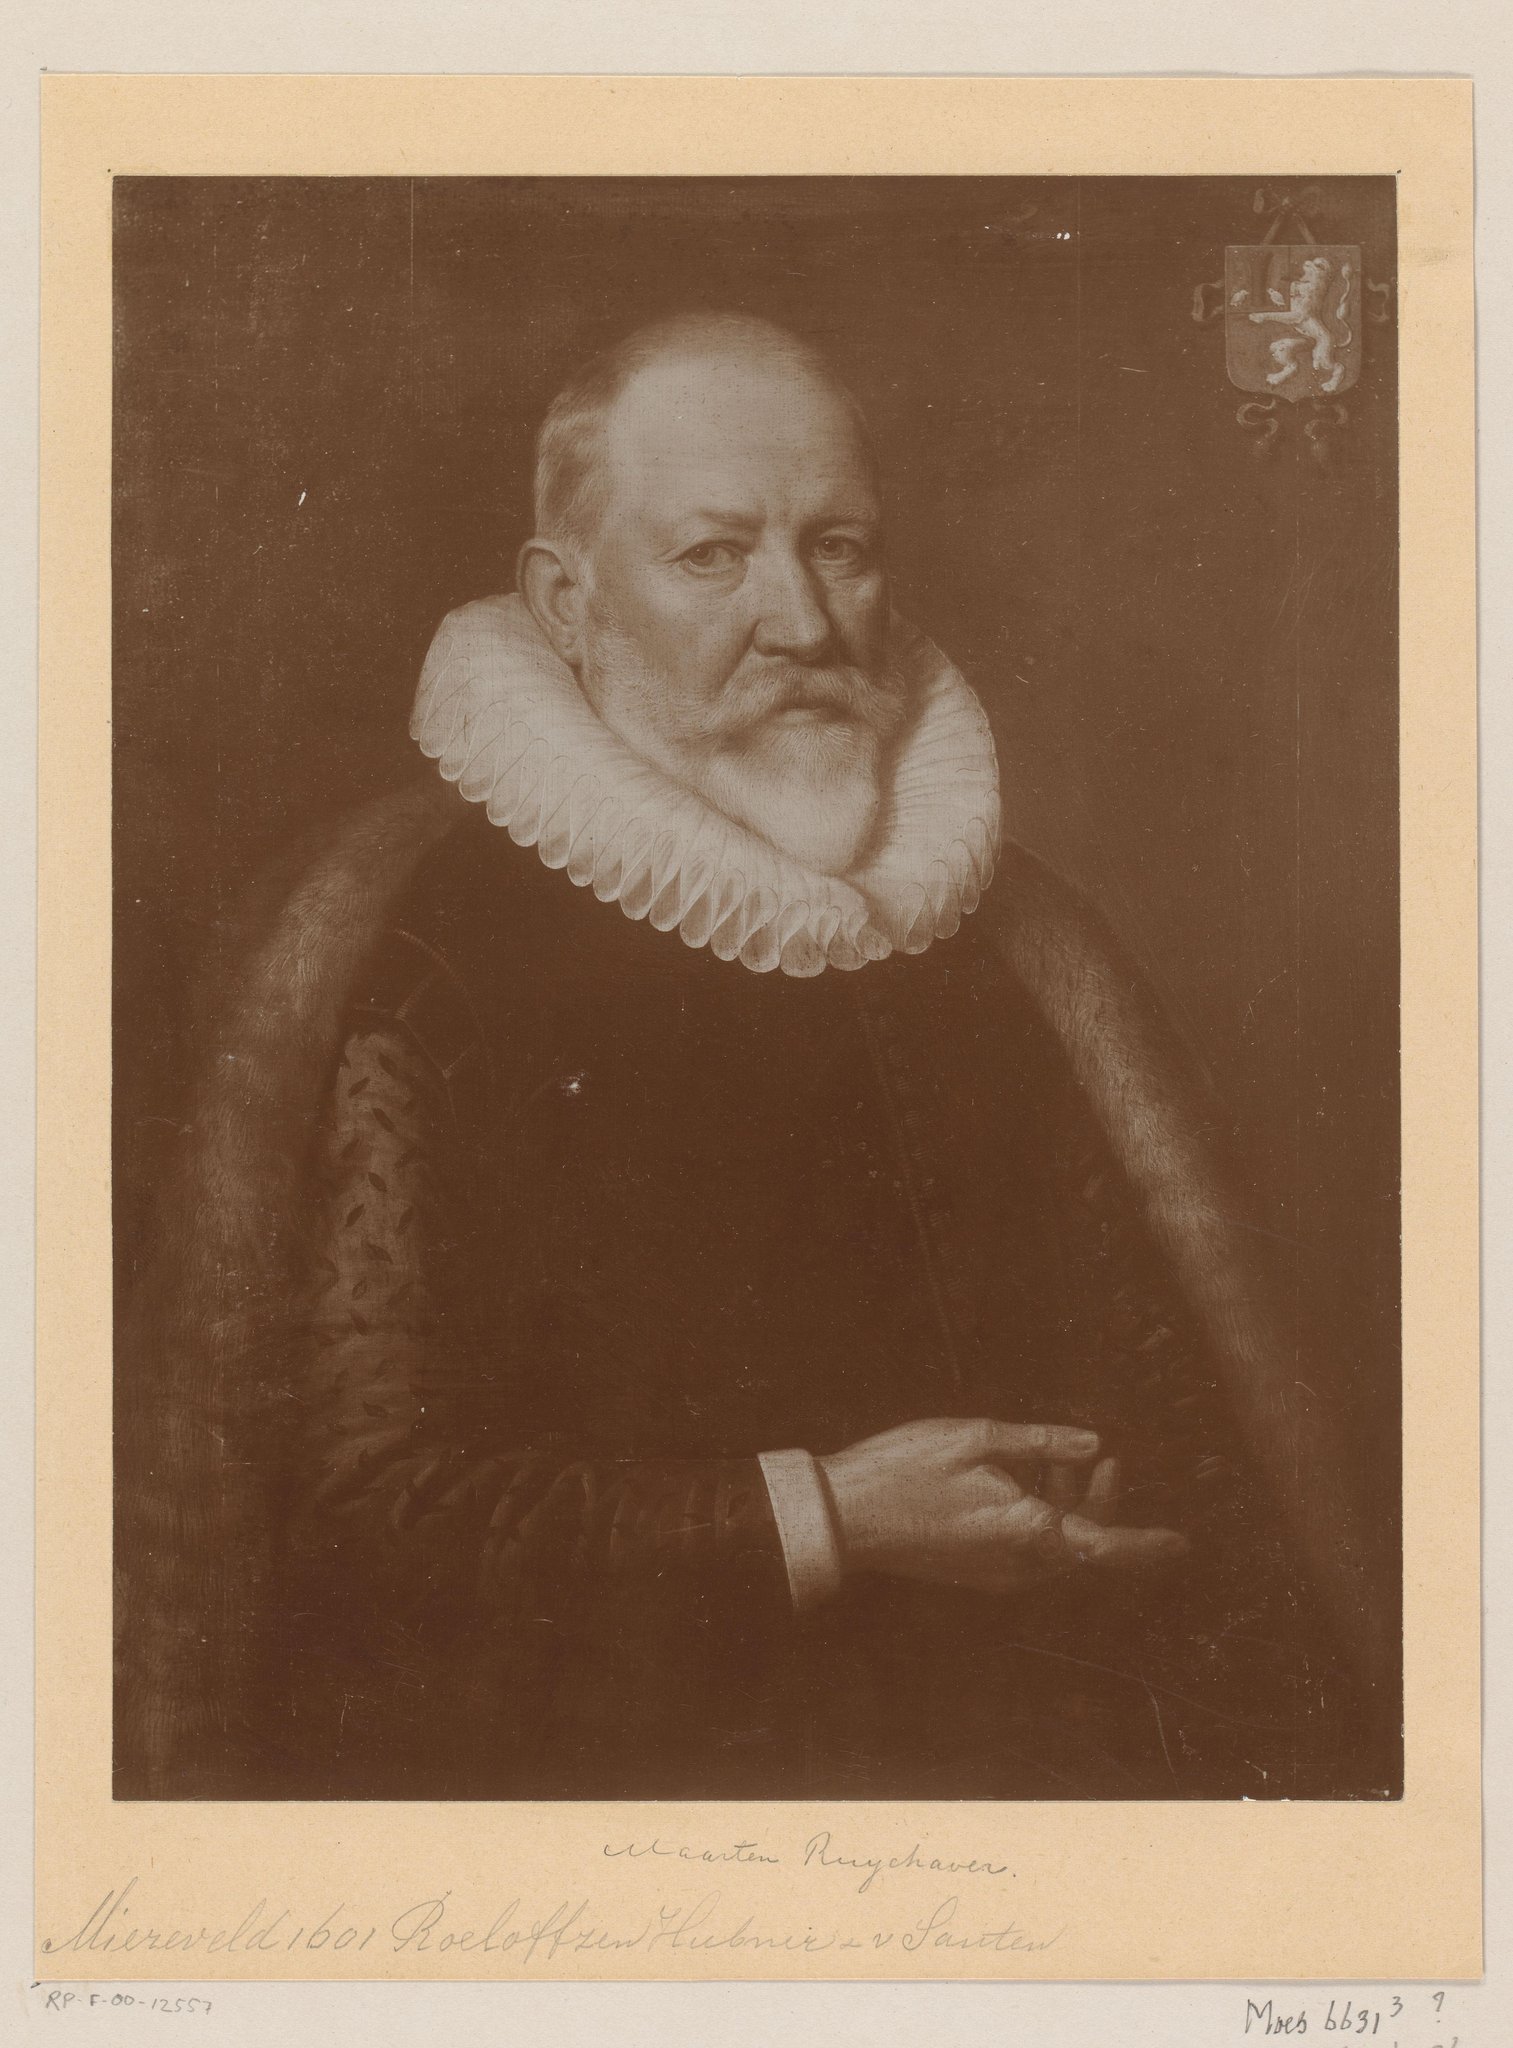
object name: photograph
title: Fotoreproductie van een geschilderd portret van Maerten Ruychaver, burgemeester van Haarlem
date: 1880-1910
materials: paper, cardboard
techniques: collodion silver print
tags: mayor, historical persons